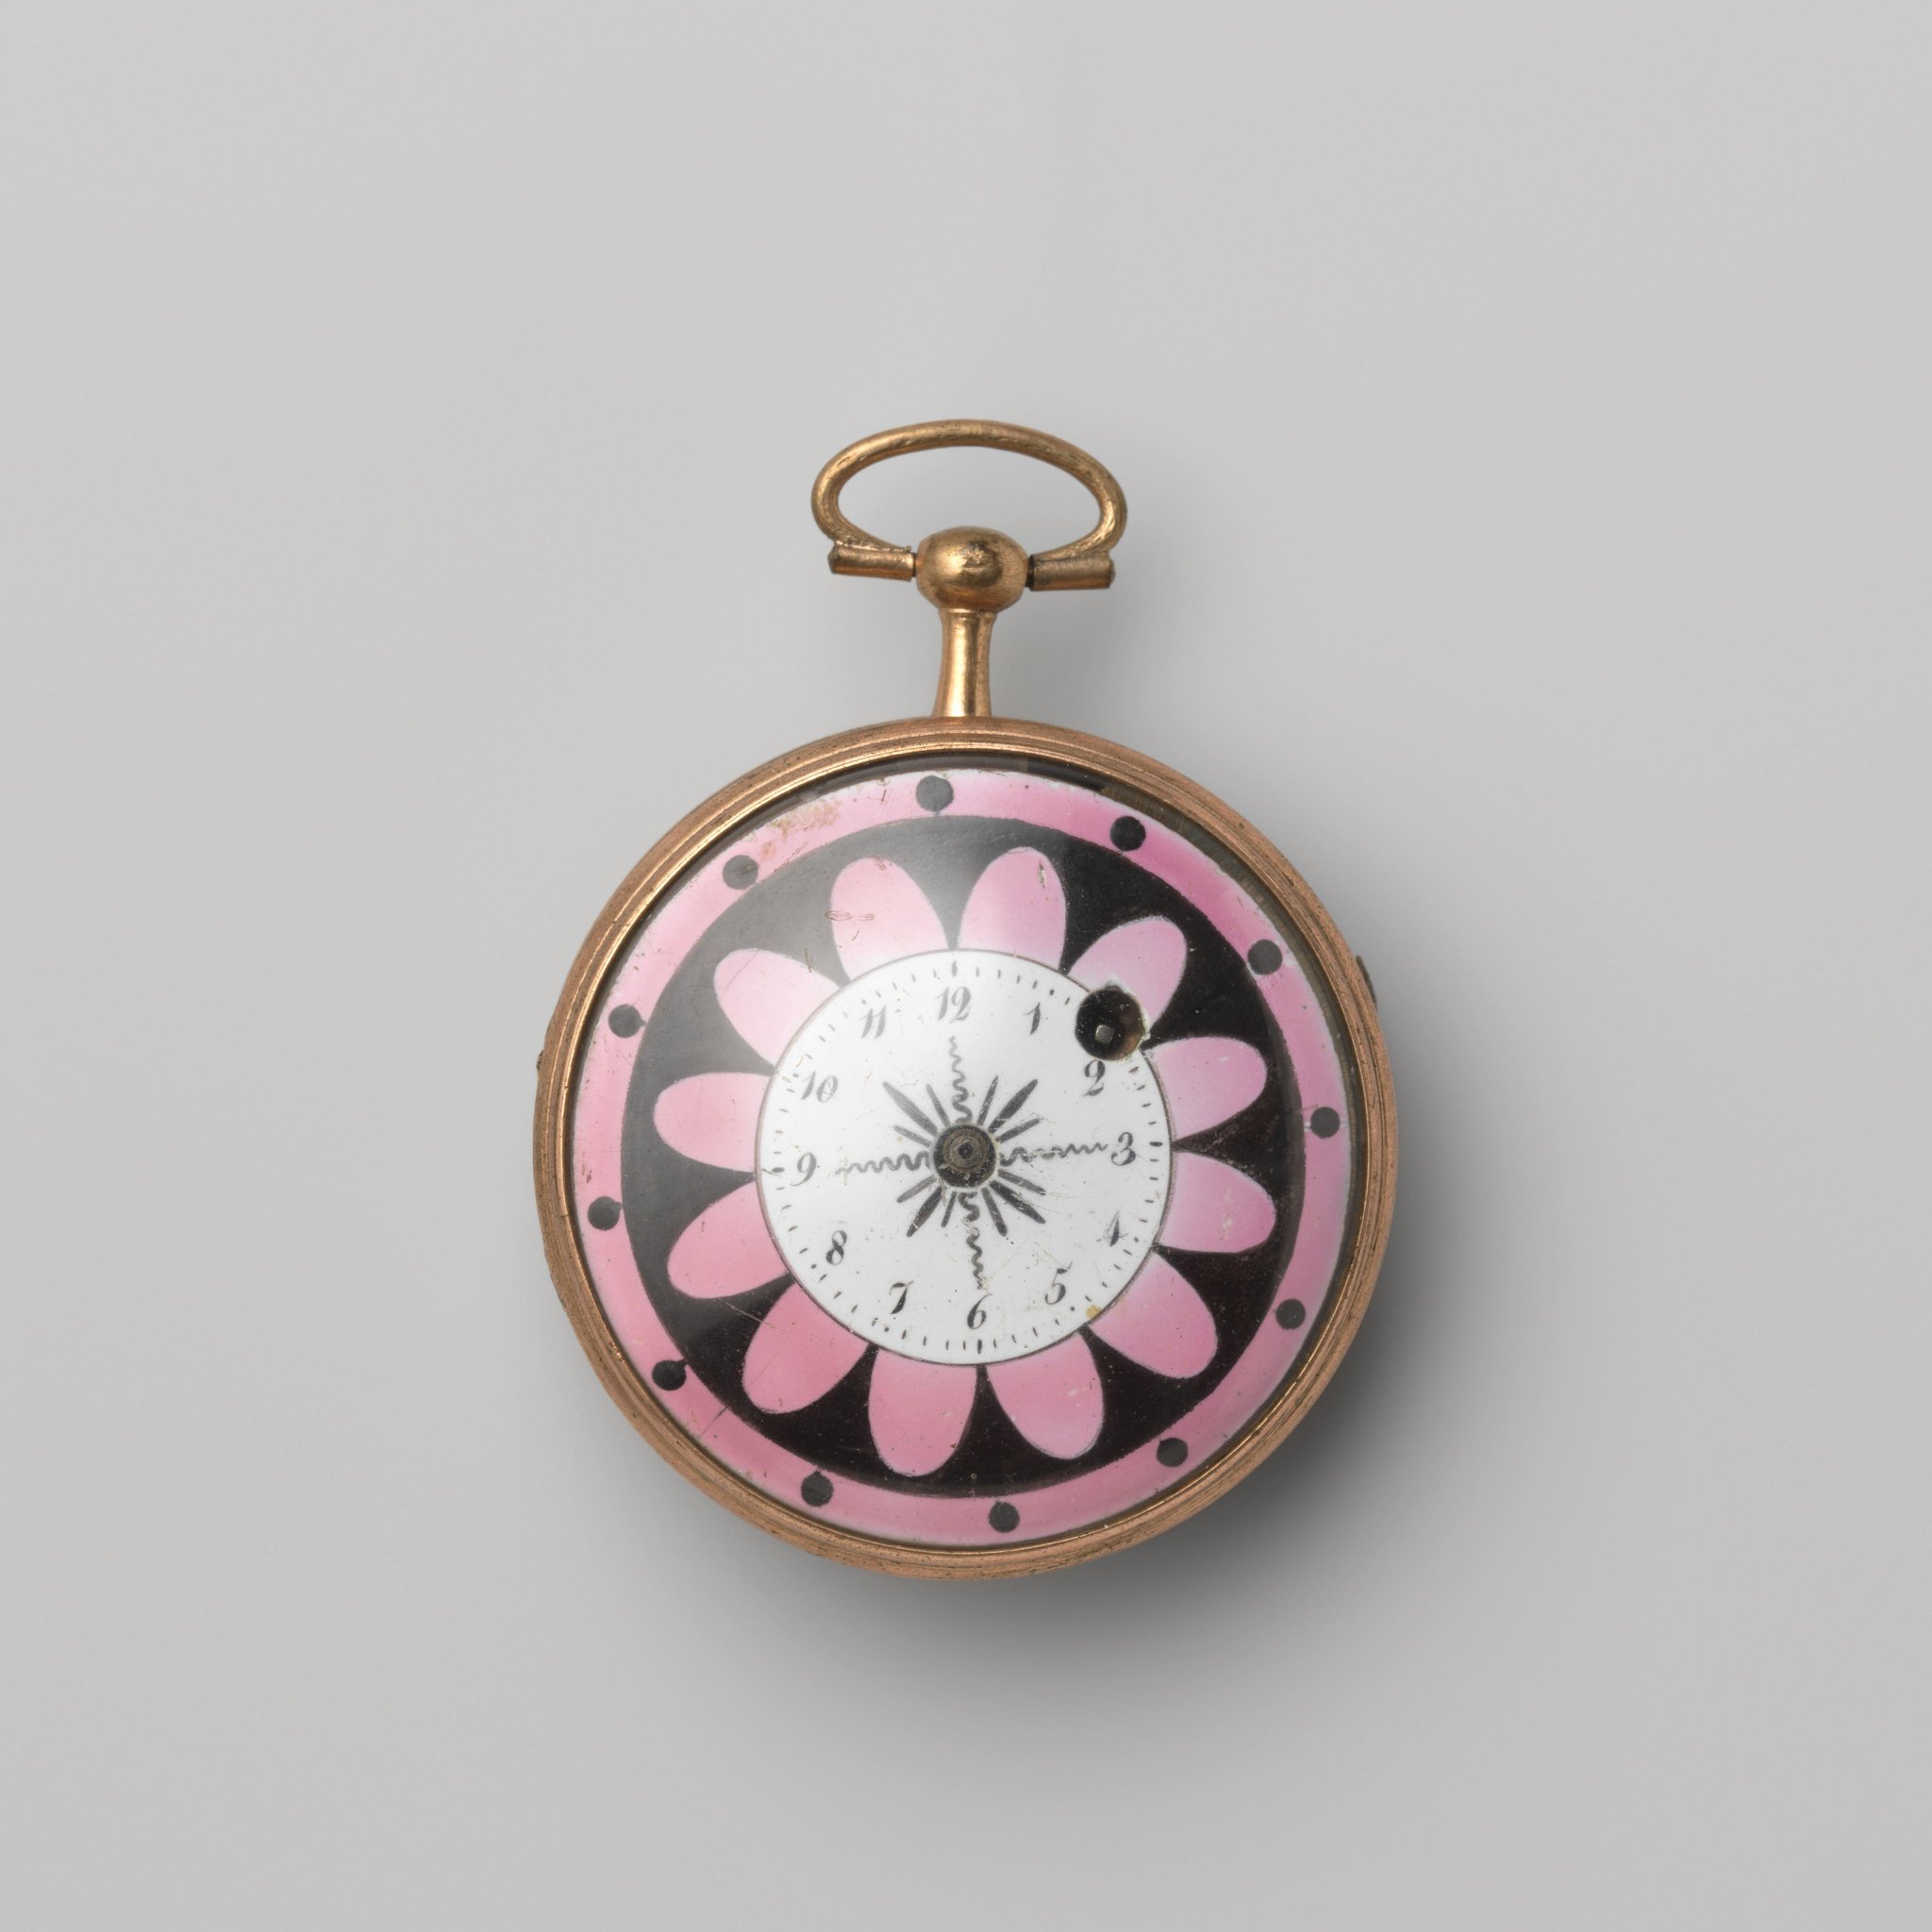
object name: jewellery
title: Herenhorloge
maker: Anonymous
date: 1800-1900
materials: gold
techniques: enameling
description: Herenhorloge van goud, met gladde achterbodem. De geëmailleerde wijzerplaat heeft een wit rondsel met Arabische uurcijfers, in een lila rozet op een zwarte grond.